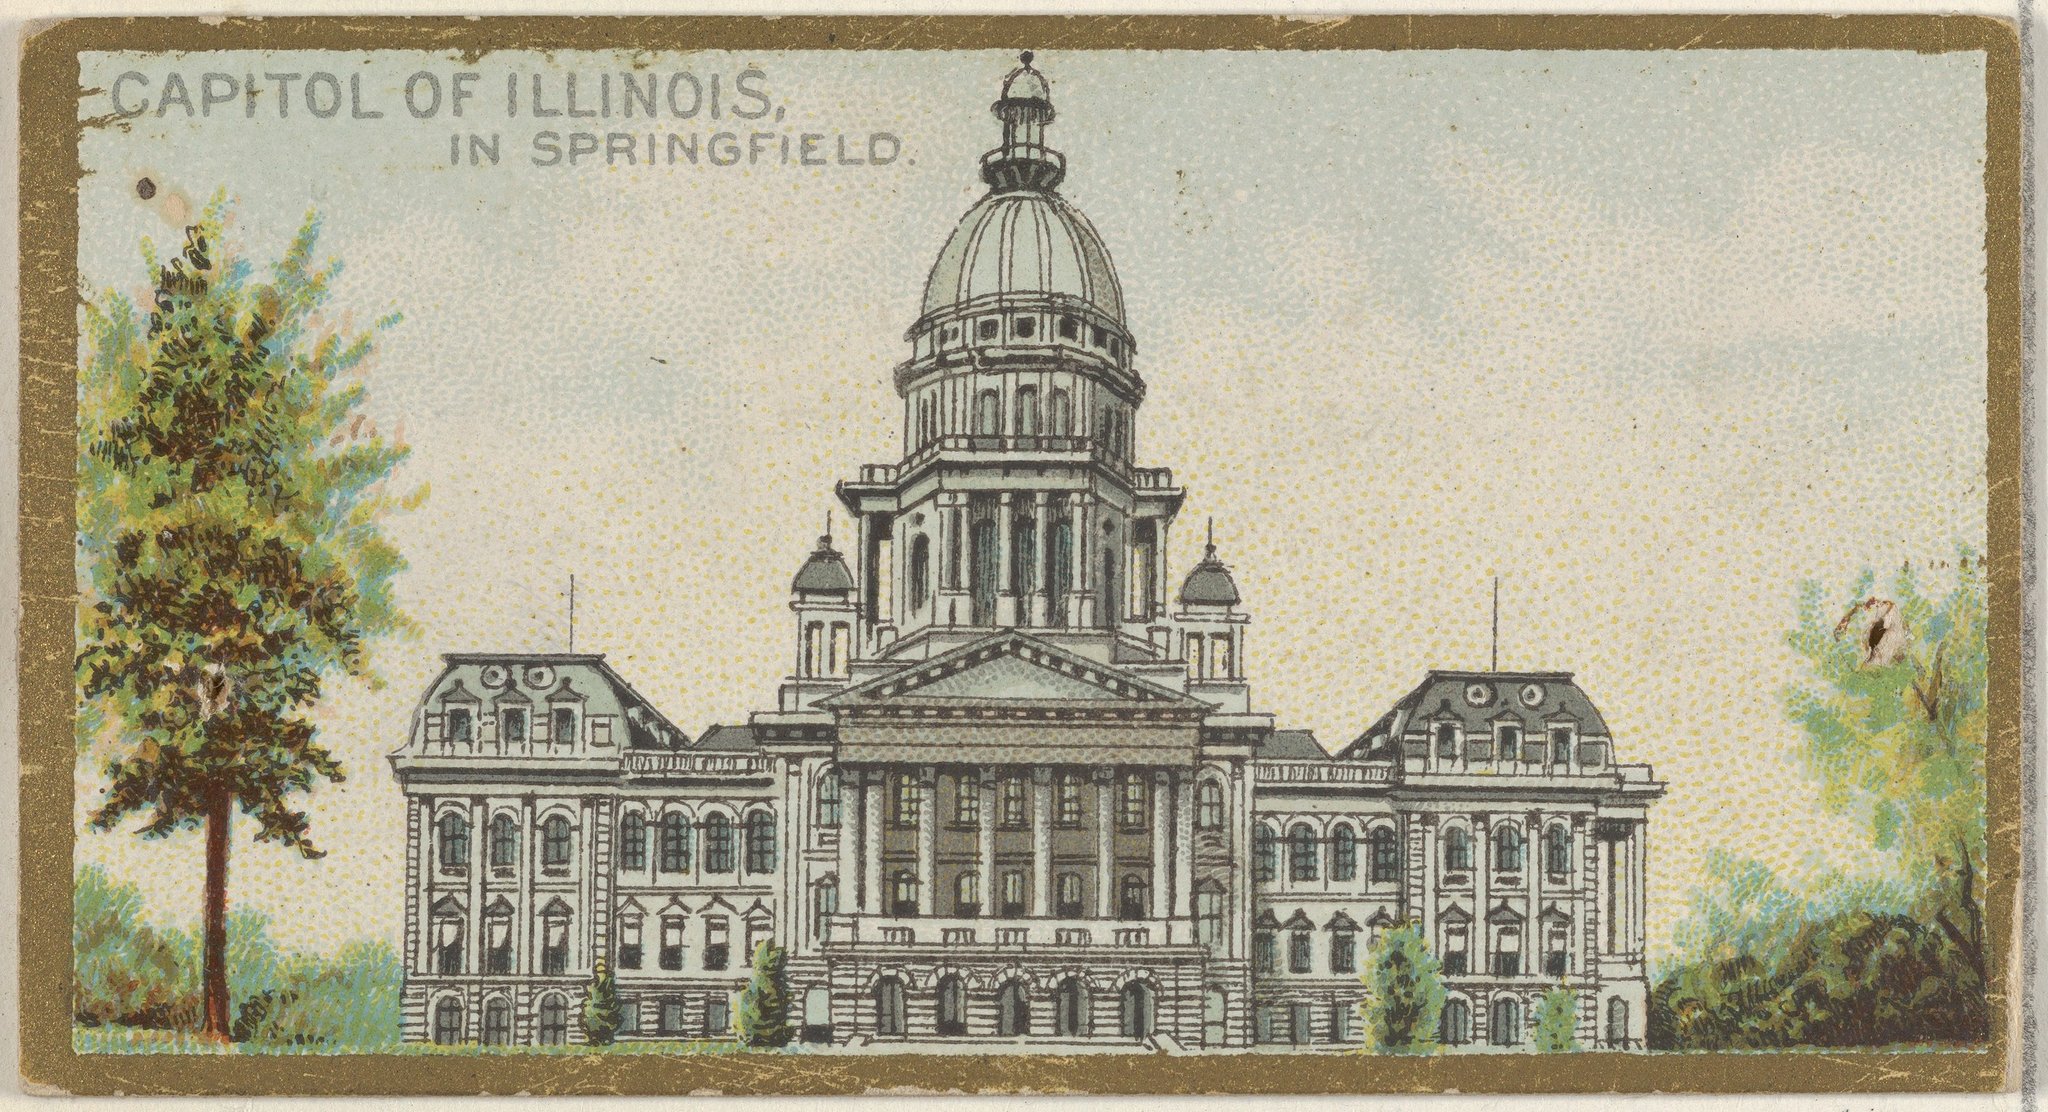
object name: print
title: Capitol of Illinois in Springfield, from the General Government and State Capitol Buildings series (N14) for Allen & Ginter Cigarettes Brands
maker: allen & ginter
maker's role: publisher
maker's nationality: american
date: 1889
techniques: color lithograph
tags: buildings